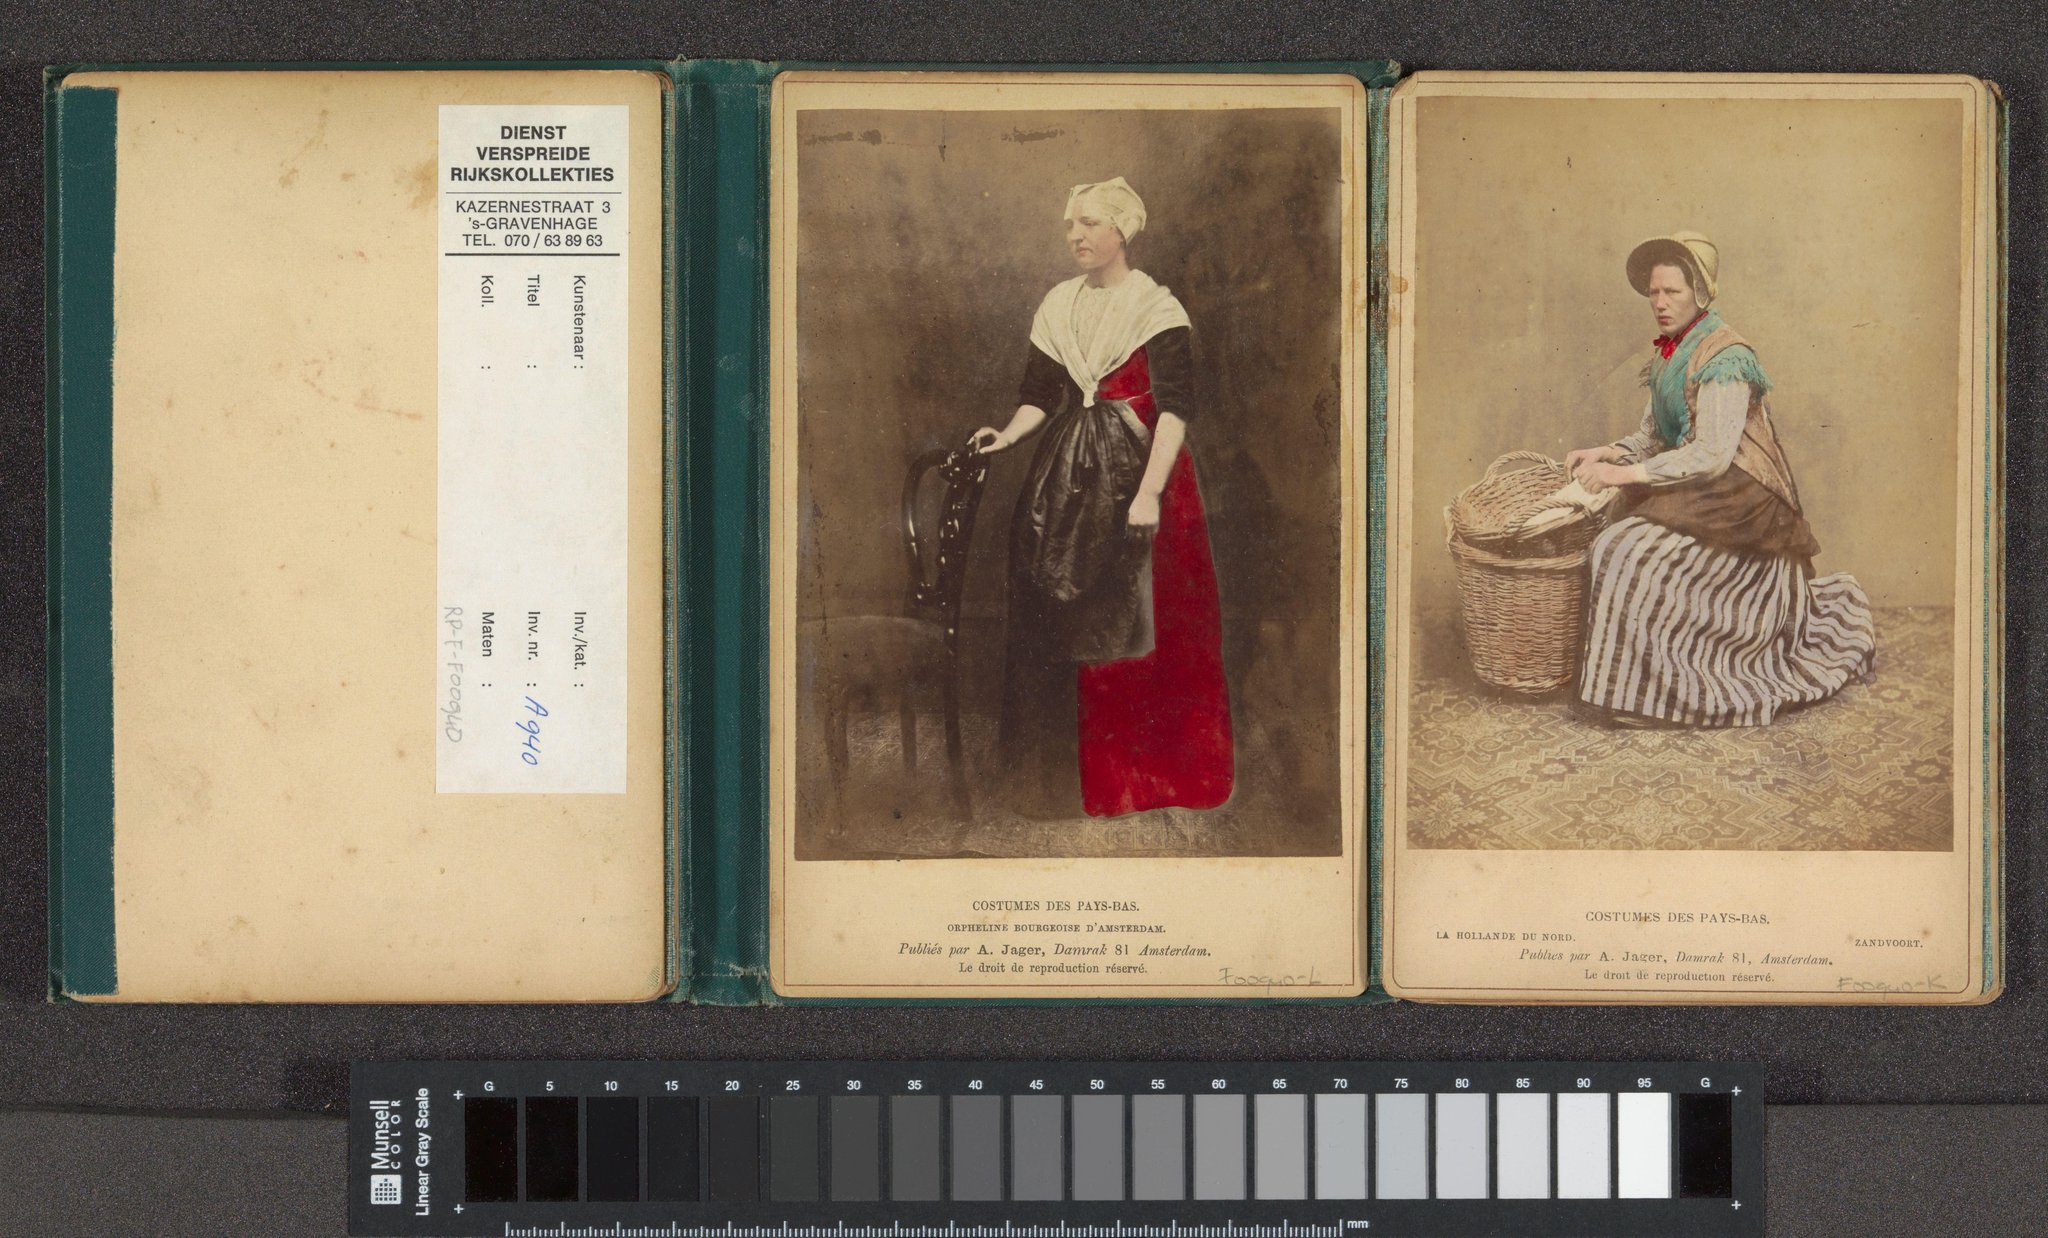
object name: photograph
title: Portret van een vrouw in de klederdracht van Zandvoort met een mand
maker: andries jager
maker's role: publisher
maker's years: 1825-1905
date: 1870-1890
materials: cardboard, paper, photographic support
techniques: albumen print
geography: amsterdam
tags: folk costume, regional costume (+ women's clothes), studio requisites ~ photographer, container made of plant material other than wood: basket, folk costume, regional costume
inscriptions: inscription: ‘Costumes des Pays-Bas. Publiés par A. Jager, Damrak 81 Amsterdam Le droit de reproduction réservé.’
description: Onderdeel van Fotoalbum met klederdrachten van Nederland.